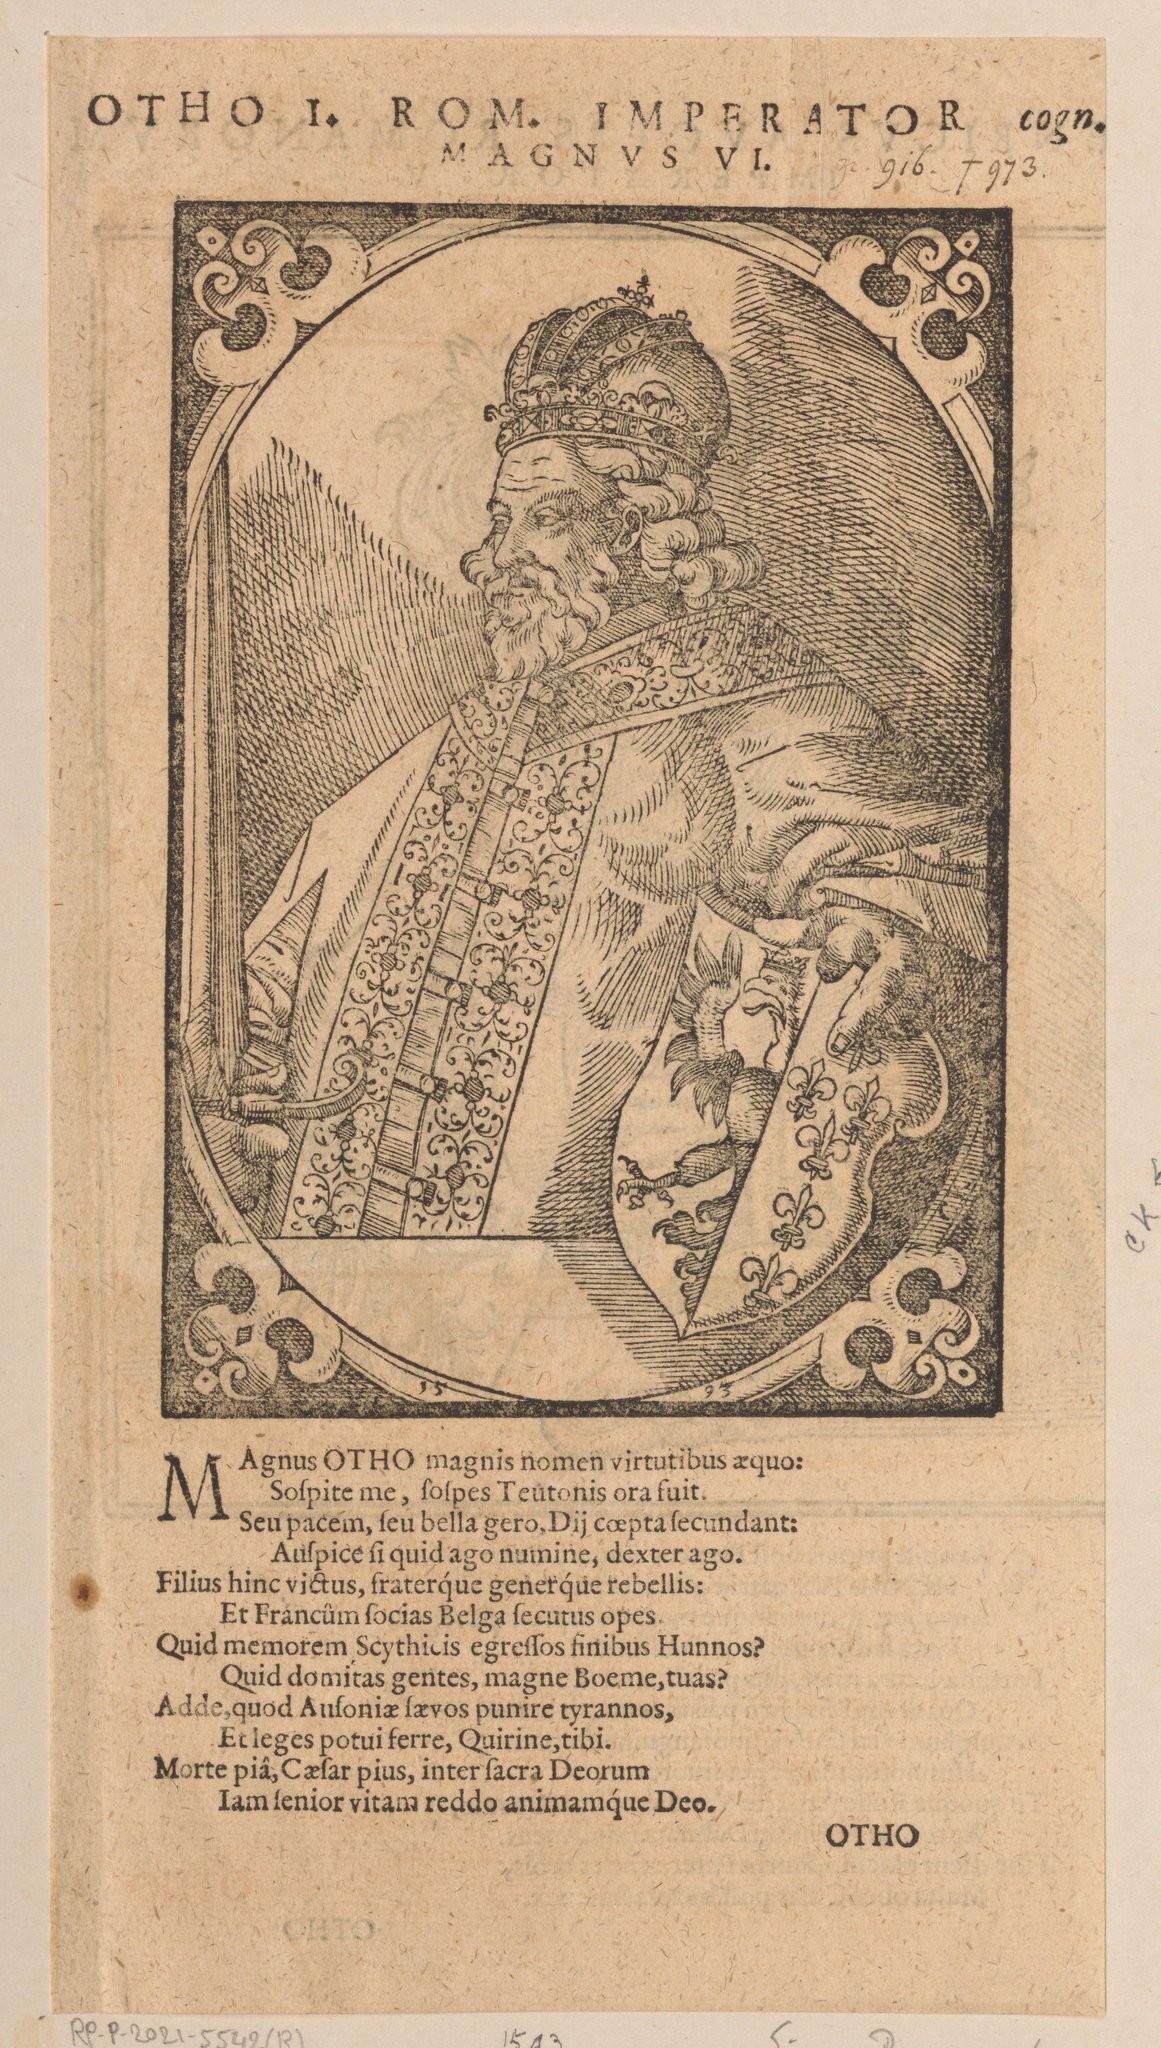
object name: book illustration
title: Portret van Otto I, keizer van het Heilige Roomse Rijk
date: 1593-1610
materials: paper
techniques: letterpress printing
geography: leipzig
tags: historical persons, armorial bearing, heraldry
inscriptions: signature: ‘CK’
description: Prent uit: Reusner, Elias. Genealogiae regum electorum ducum (...). Leipzig: Henning Grosse I, 1610. Of een eerdere publicatie (1597).